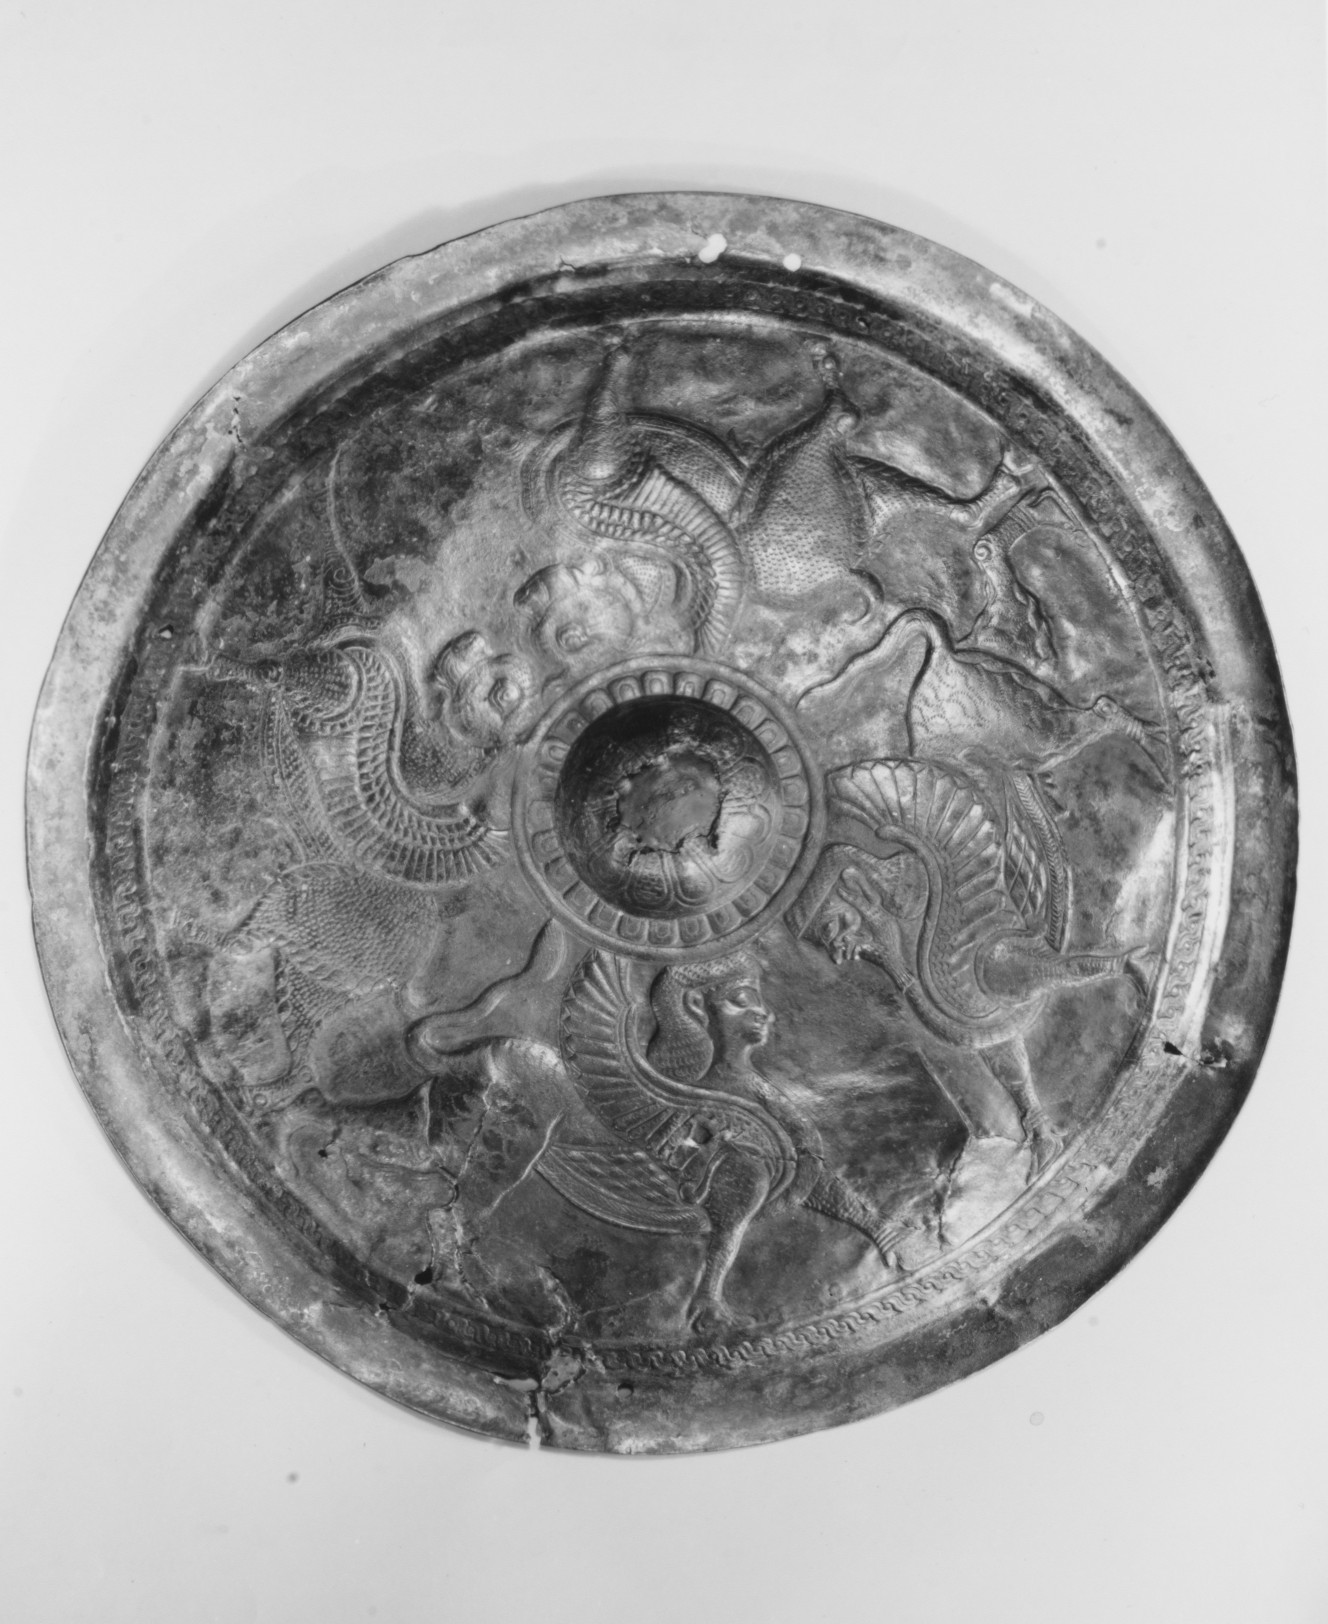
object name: disc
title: Disc with sphinxes and winged bulls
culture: iranian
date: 1000-801 BCE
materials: bronze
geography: western iran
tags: sphinx